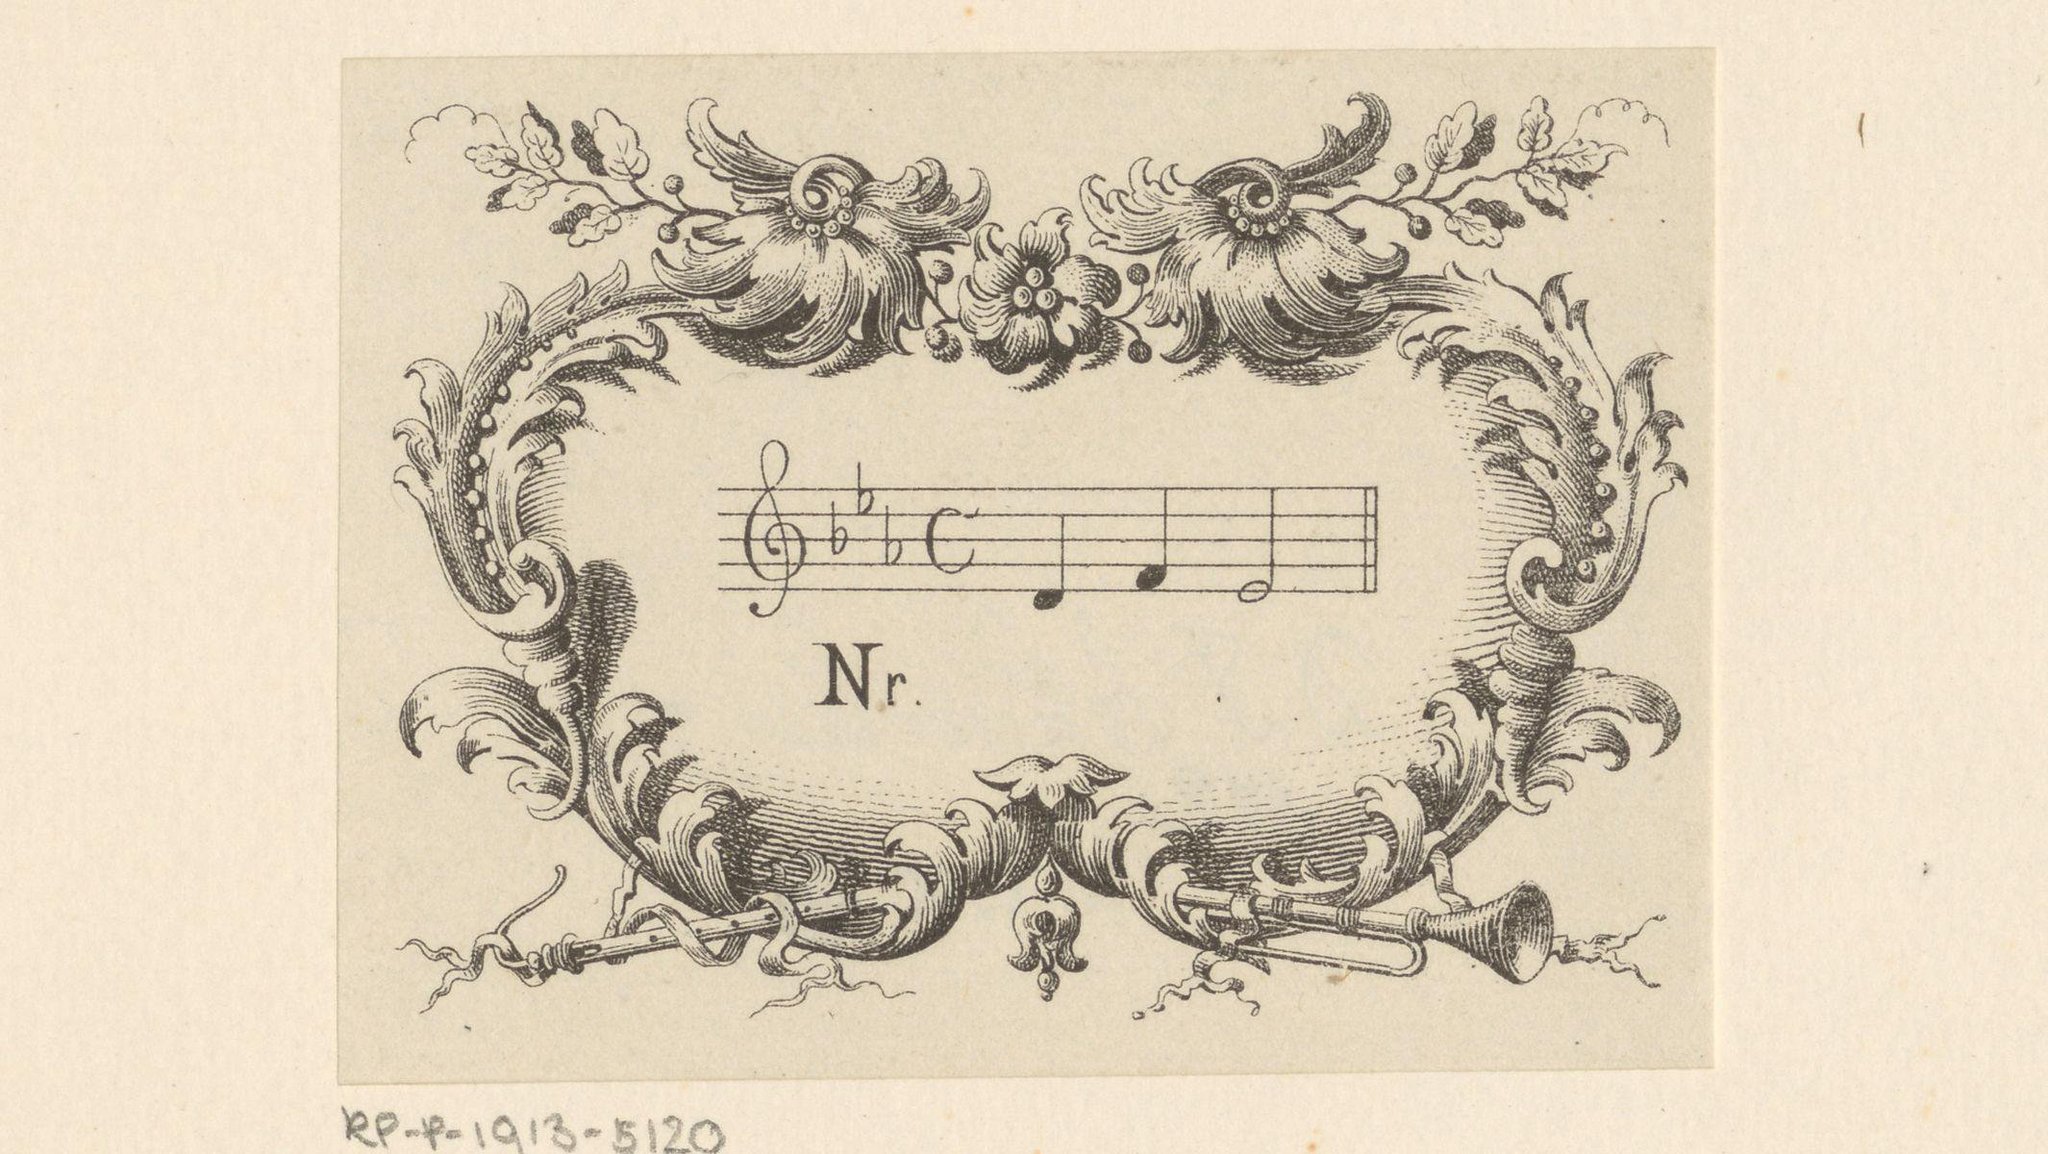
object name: bookplate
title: Ex libris van Daniël François Scheurleer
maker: Anonymous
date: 1865-1913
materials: paper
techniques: printing block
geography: netherlands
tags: daniël françois scheurleer, notation of music, horn, trumpet, cornet, trombone, tuba, ornament ~ festoon, garland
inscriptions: collector's mark: Lugt 2760, collector's mark: Lugt 2233